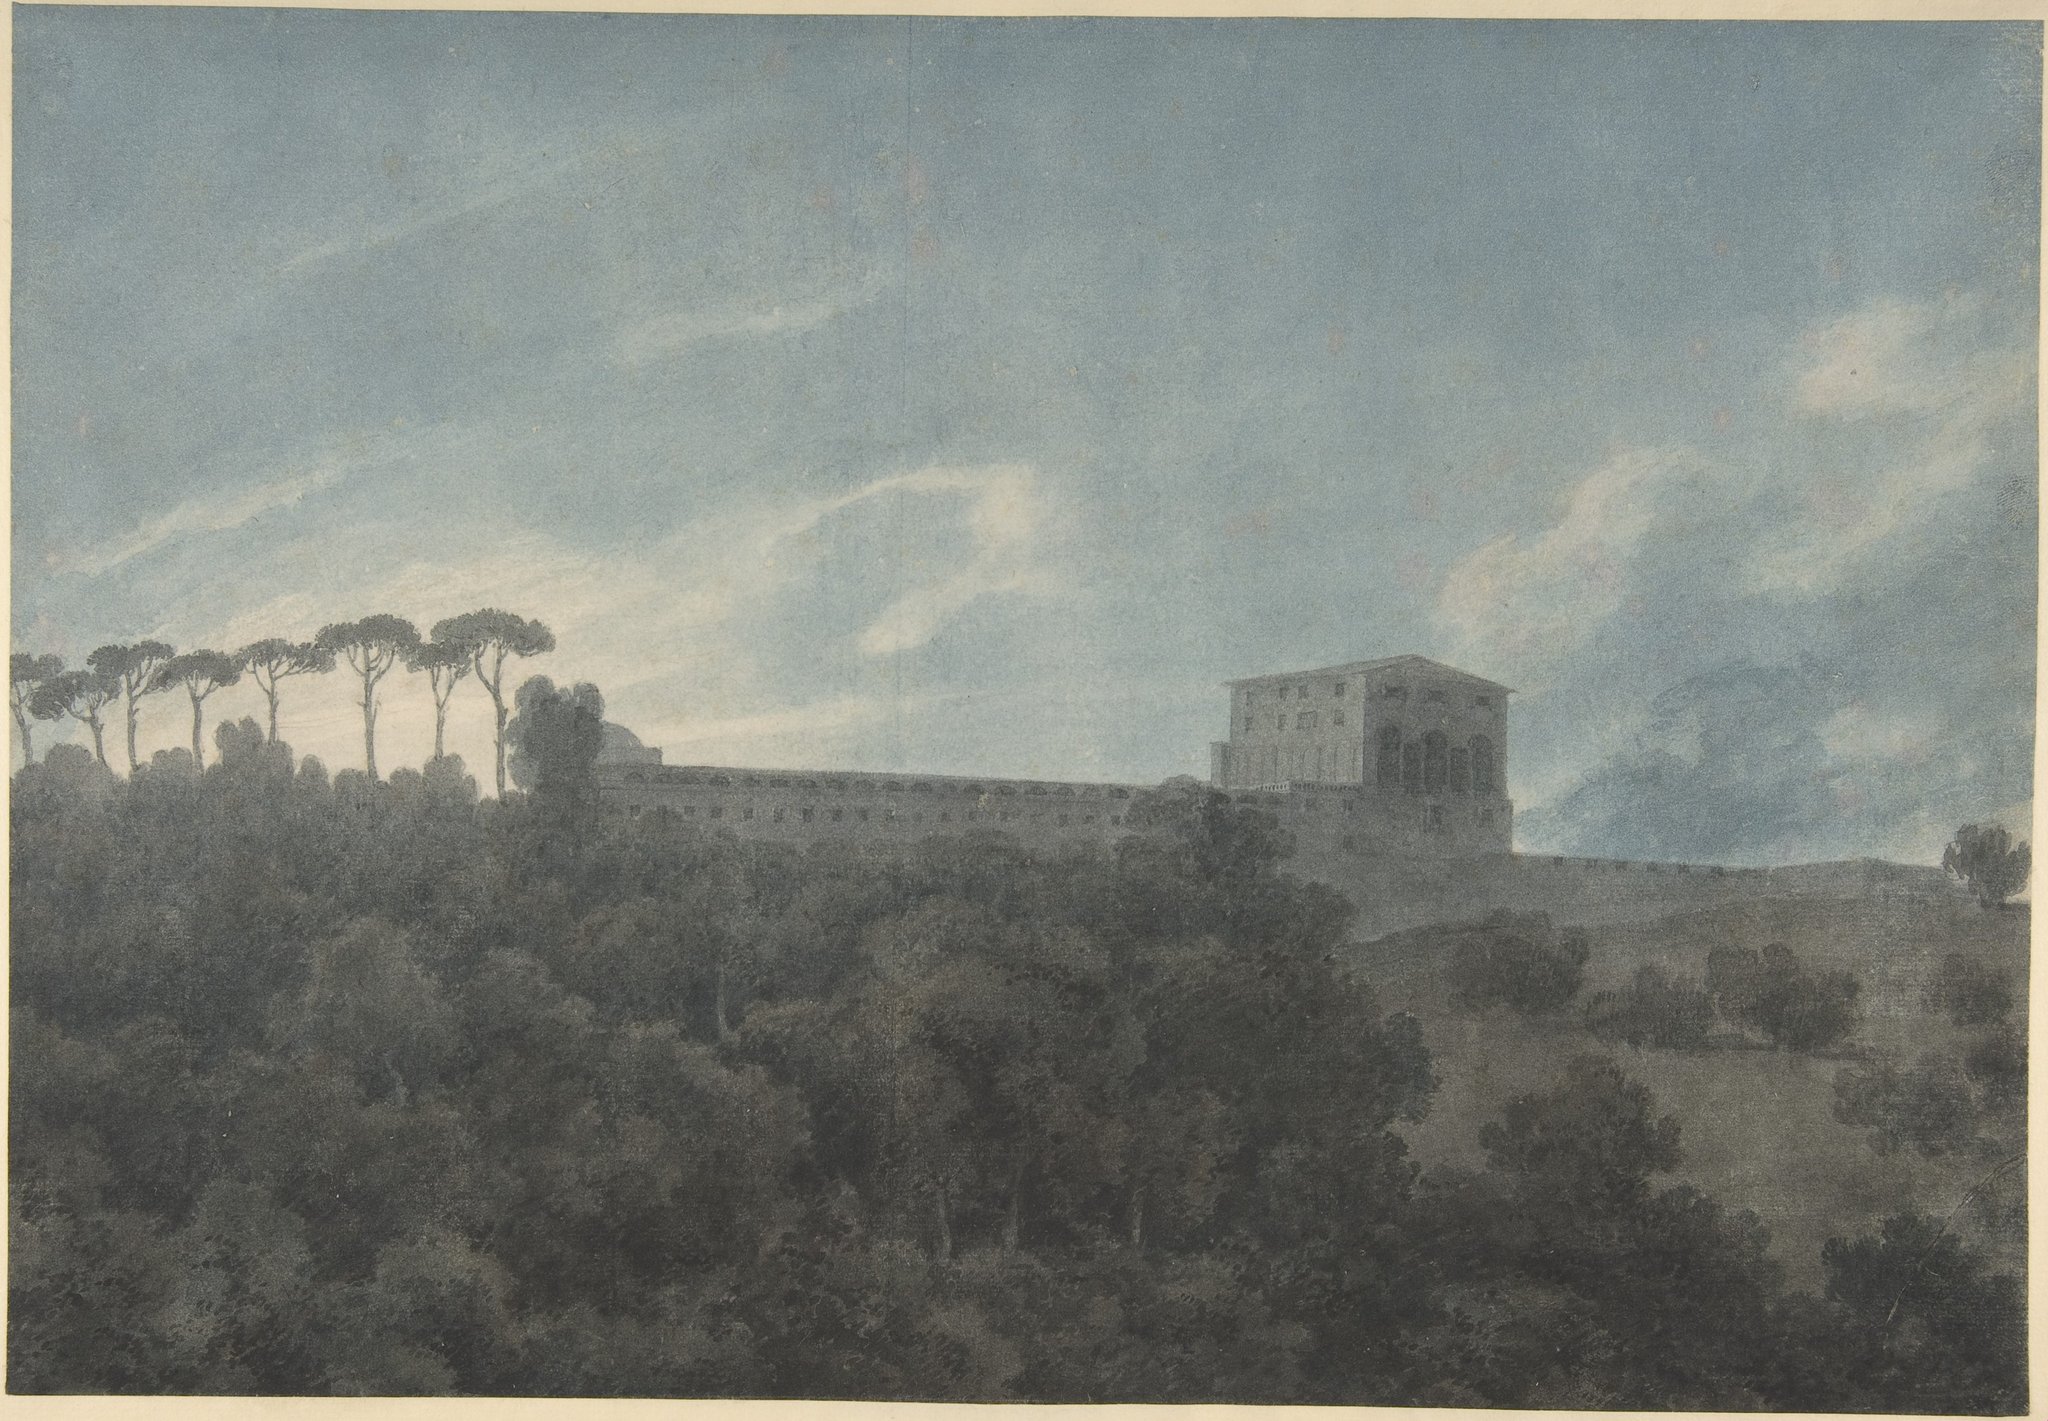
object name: drawing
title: View of the Villa Lante on the Janiculum in Rome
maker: john robert cozens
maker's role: artist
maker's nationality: british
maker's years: 1752-1797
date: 1782-1783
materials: graphite, watercolor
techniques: brush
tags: buildings,landscapes,rome